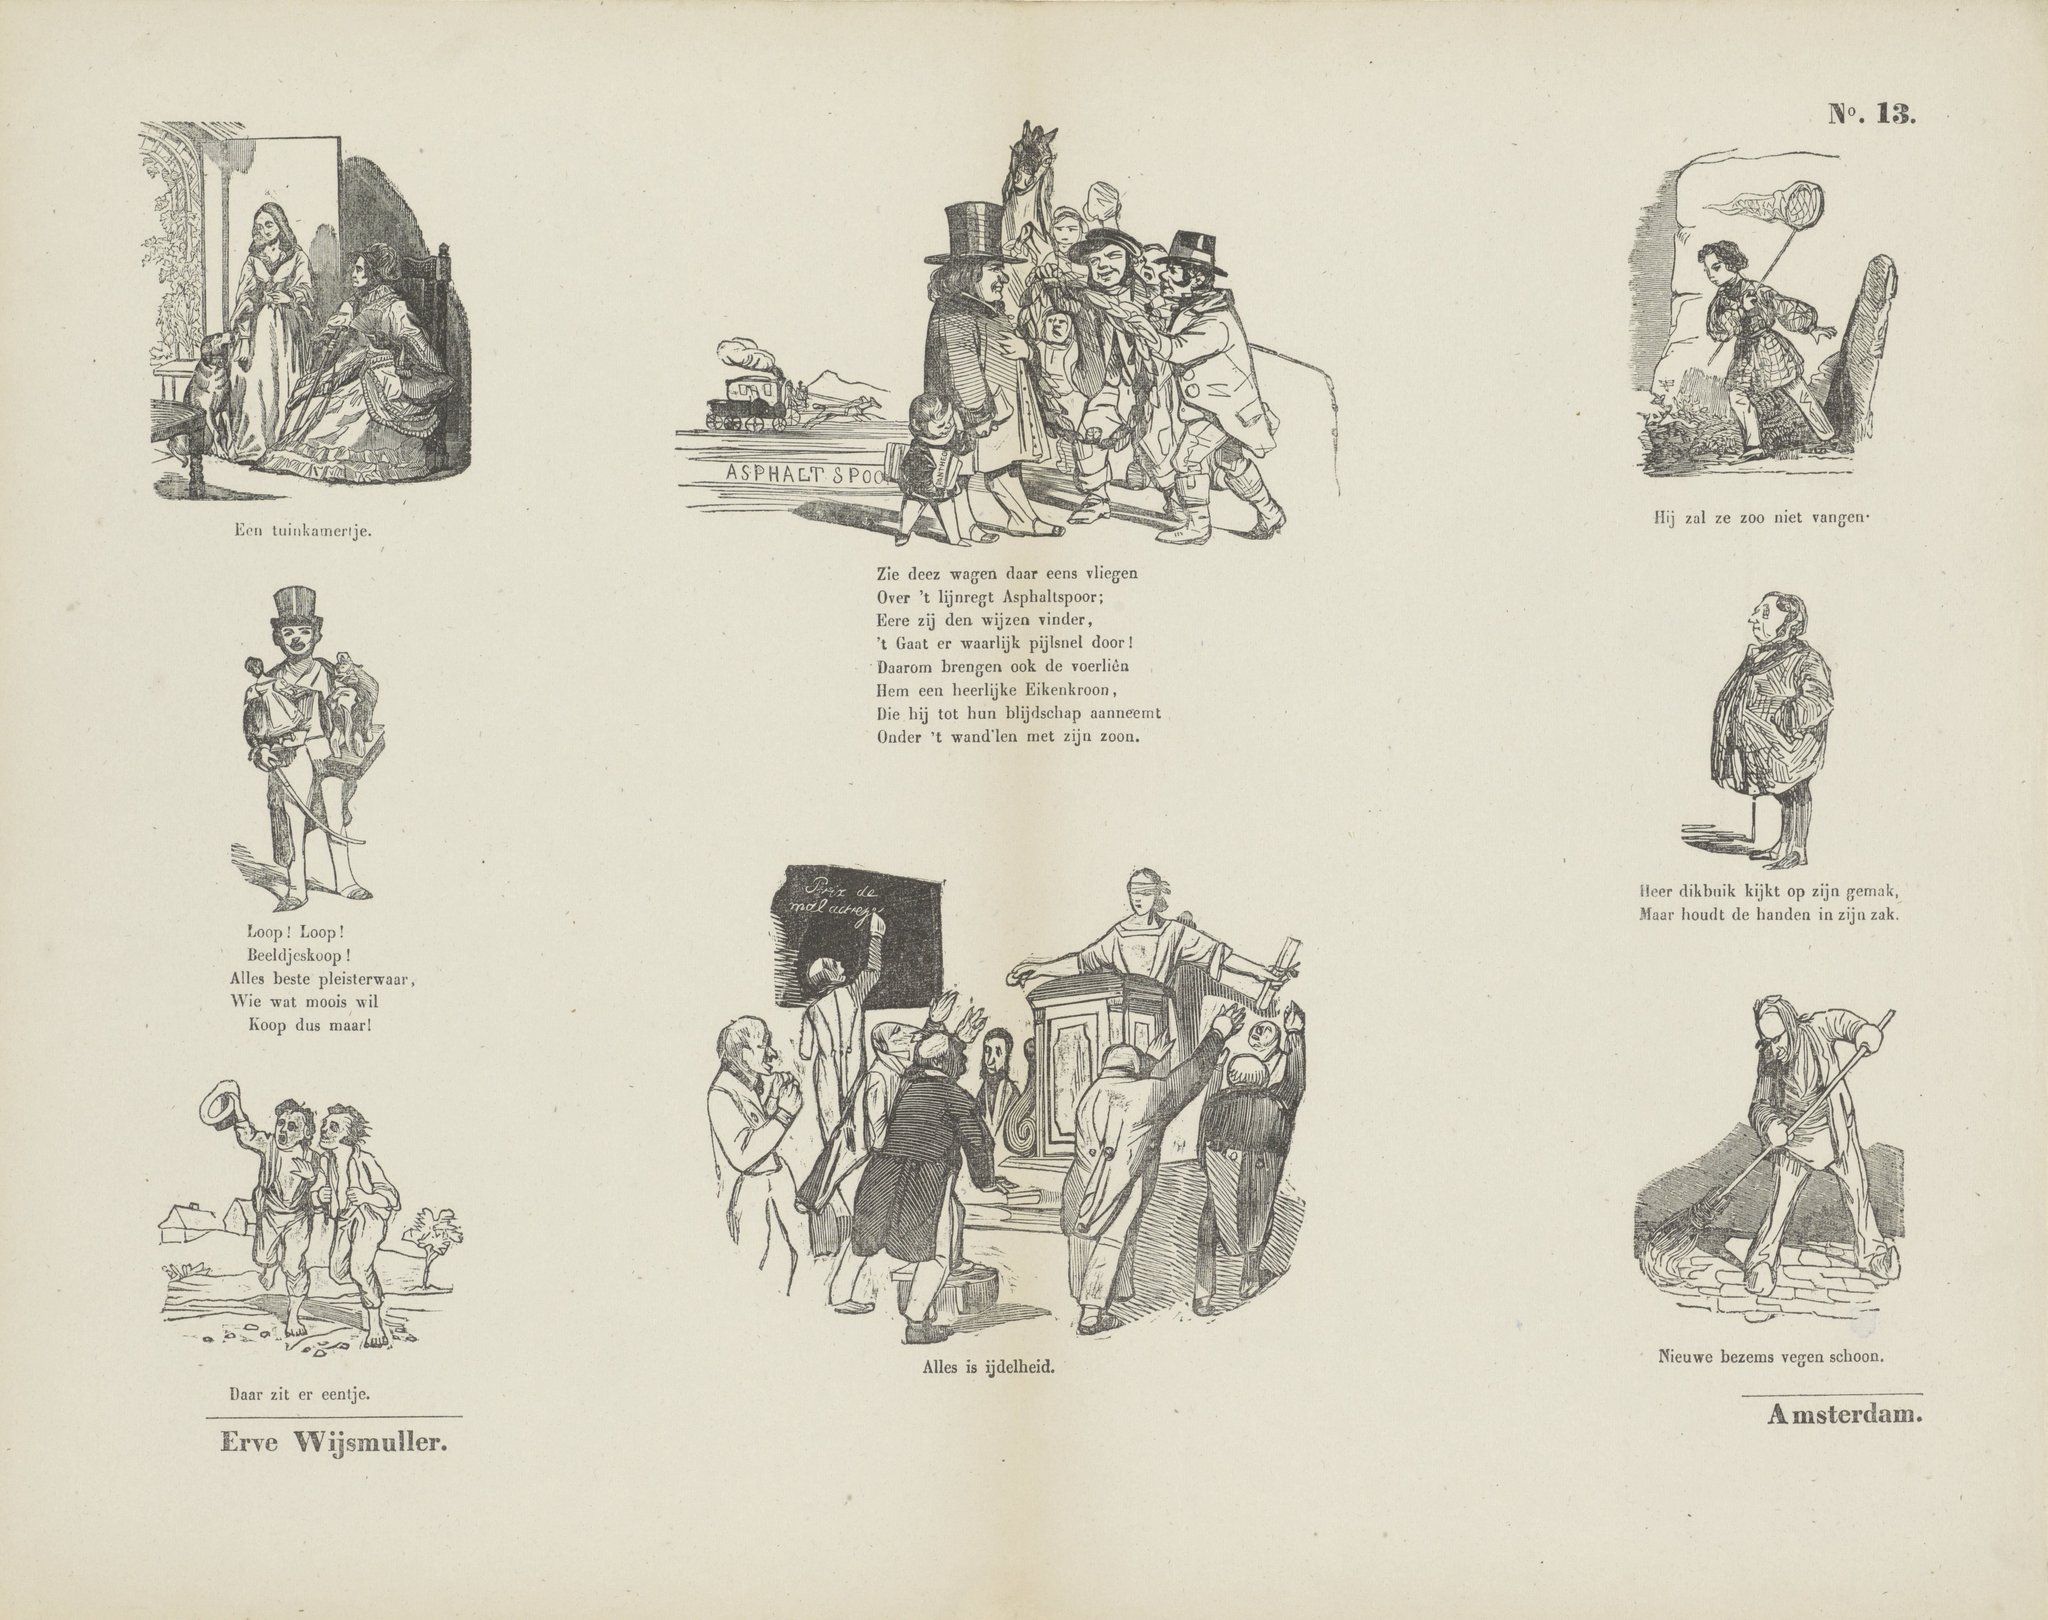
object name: print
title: Verschillende voorstellingen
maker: Anonymous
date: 1828-1913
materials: paper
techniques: letterpress printing, line block, engraving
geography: amsterdam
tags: street-trader, hunting butterflies, merchant, salesman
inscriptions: collector's mark: Lugt 2760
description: Blad met 8 voorstellingen van verschillende aard, waaronder een vlindervanger en een beeldenkoopman. Onder elke afbeelding een onderschrift. Onder de eerste afbeelding het onderschrift: Een tuinkamertje. Genummerd rechtsboven: No. 13.